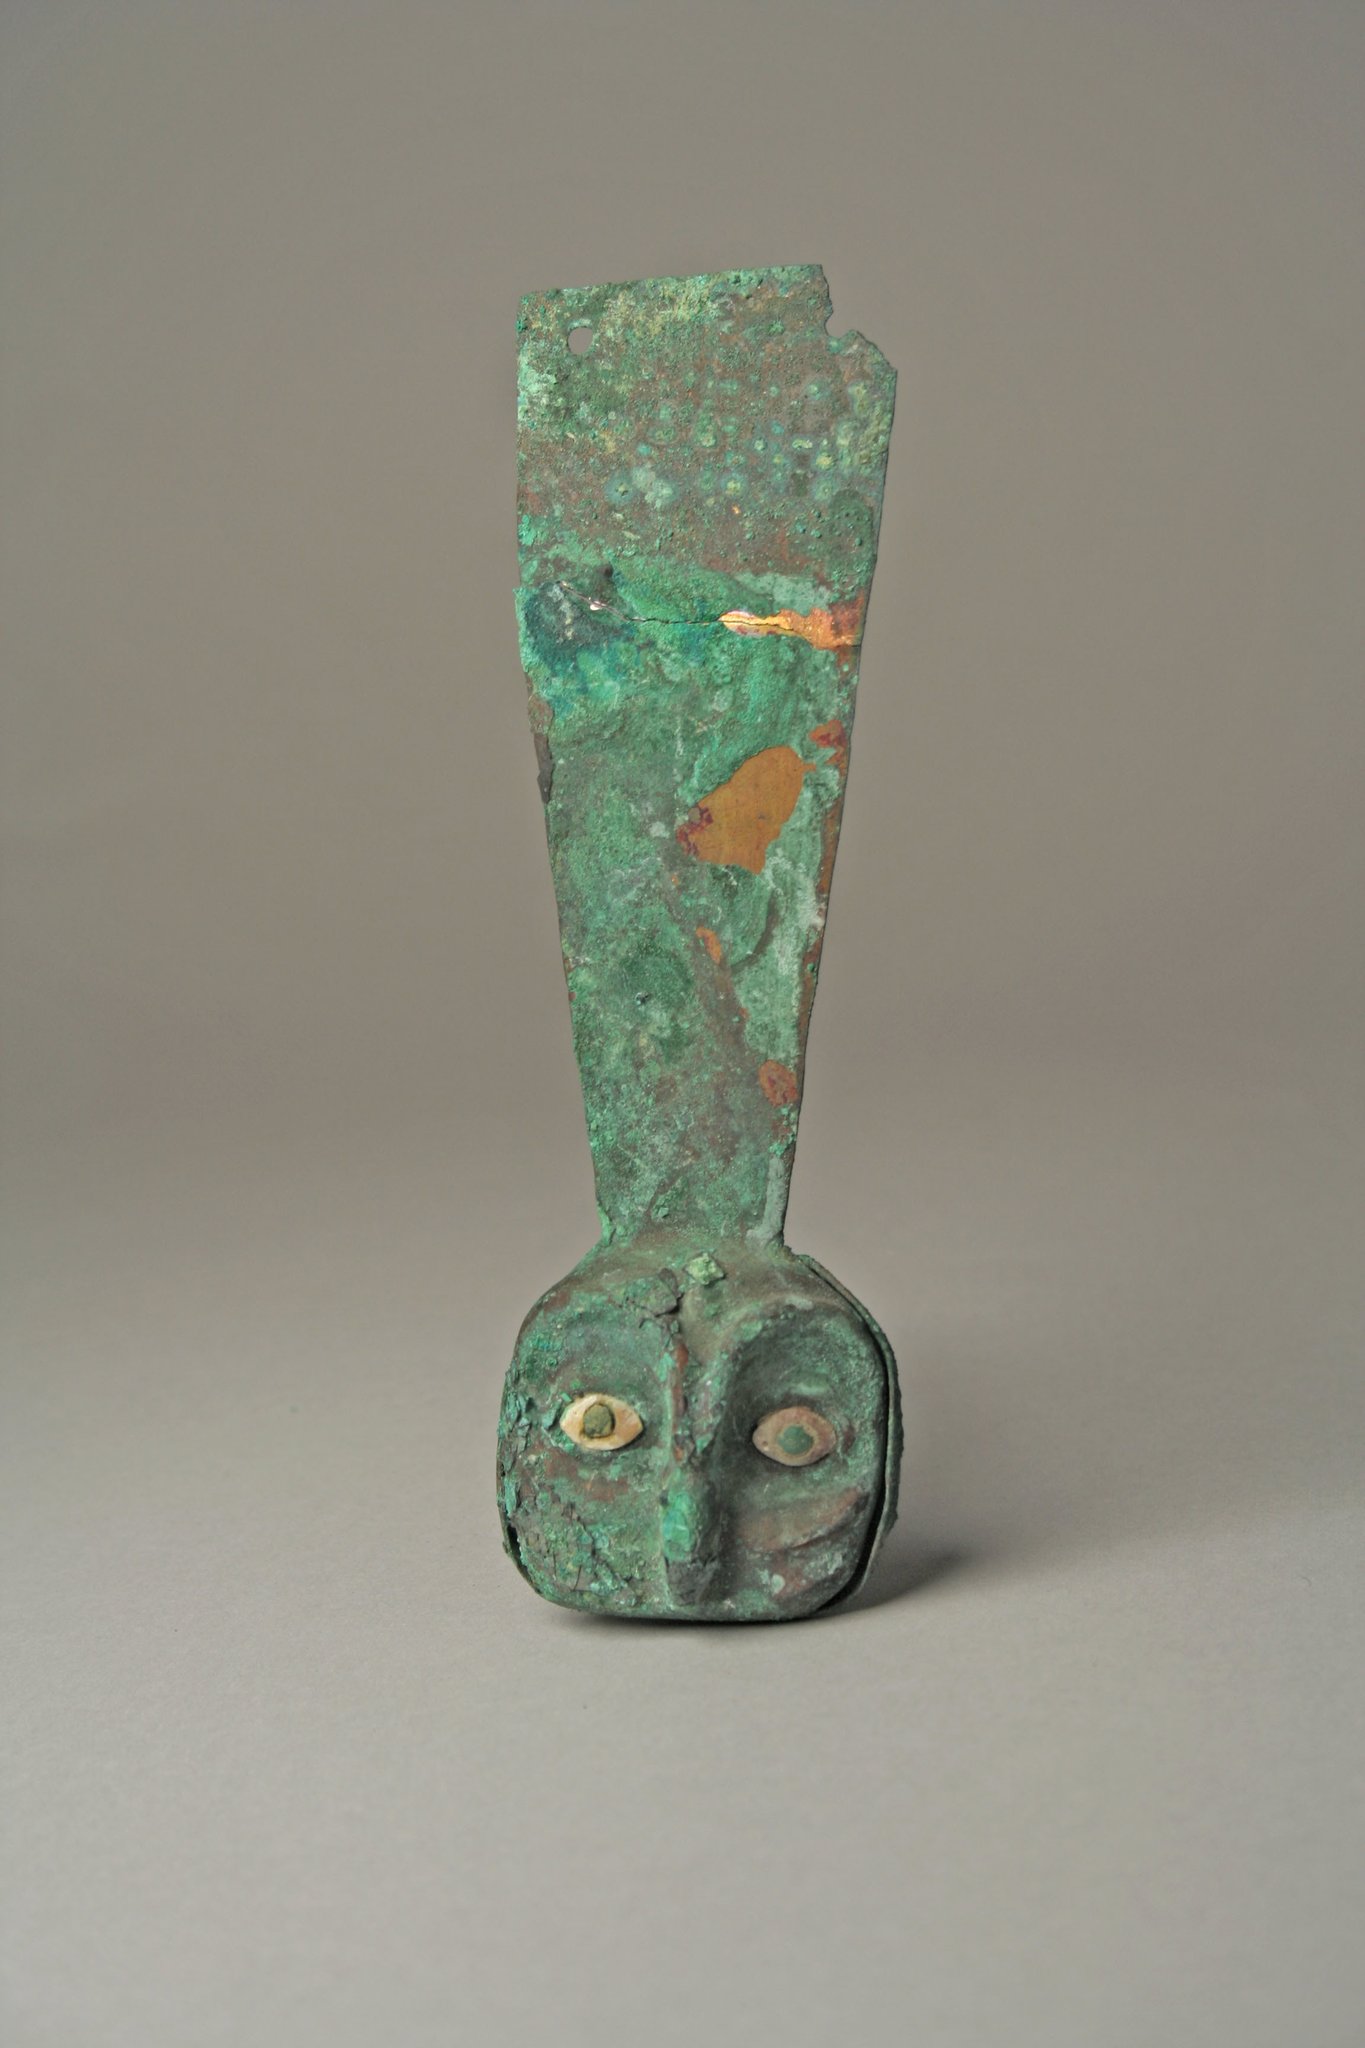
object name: ornament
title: Owl Tab Ornament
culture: moche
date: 501-700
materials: shell, metal, stone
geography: peru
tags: owls